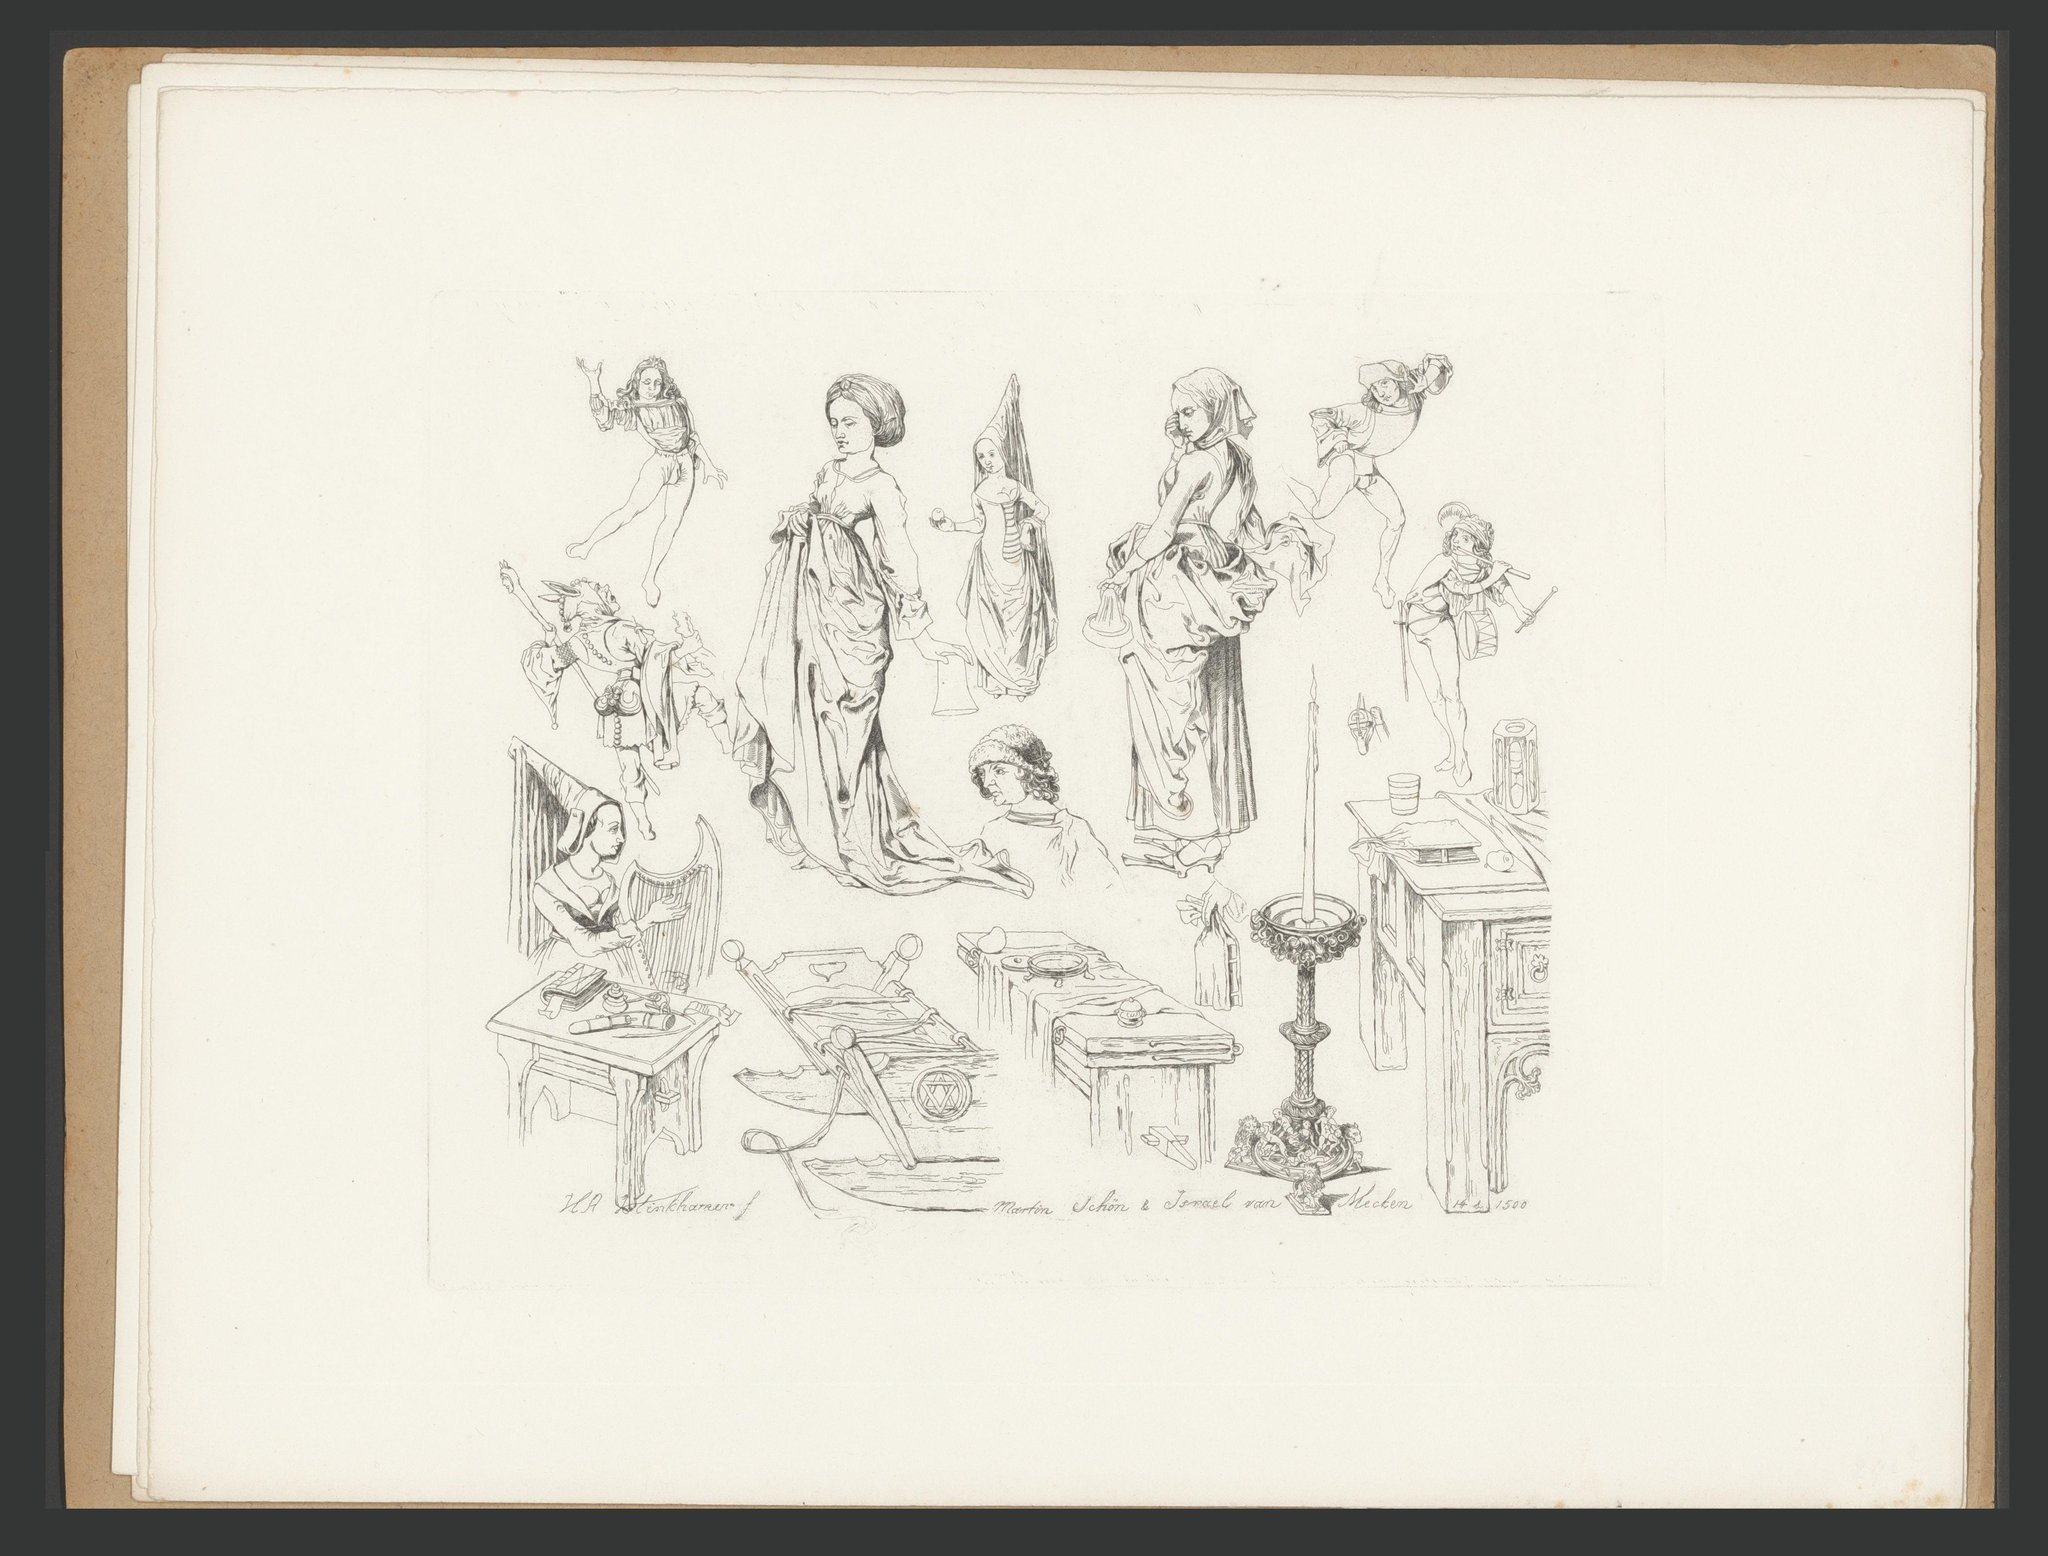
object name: print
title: Studieblad met dansende en musicerende figuren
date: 1863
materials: paper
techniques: etching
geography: amsterdam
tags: court jester, court fool, drum (musical instrument), harp, man dancing alone, attributes of court jester, candlestick, flute, aulos, tibia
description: Studieblad met dansende en musicerende figuren in Middeleeuwse kleding. Links een dansende nar met marot en rechts een man die tegelijk een fluit en een trom bespeelt. In het midden een dame met een punthoed op het hoofd en een appel in haar rechterhand. Onder een vrouw die een harp bespeelt en een puntmuts draagt. Naast haar een aantal Middeleeuwse meubels, waaronder een wieg en een gedecoreerde kaarsenstandaard. Onderwerpsrubrieken binnen de Atlas Zeden en Gewoonten: Zeden en Gewoonten in Engeren Zin, De Kleeding, Kleederdrachten (tijdvakken), De Reformatie. (1500 – 1550).